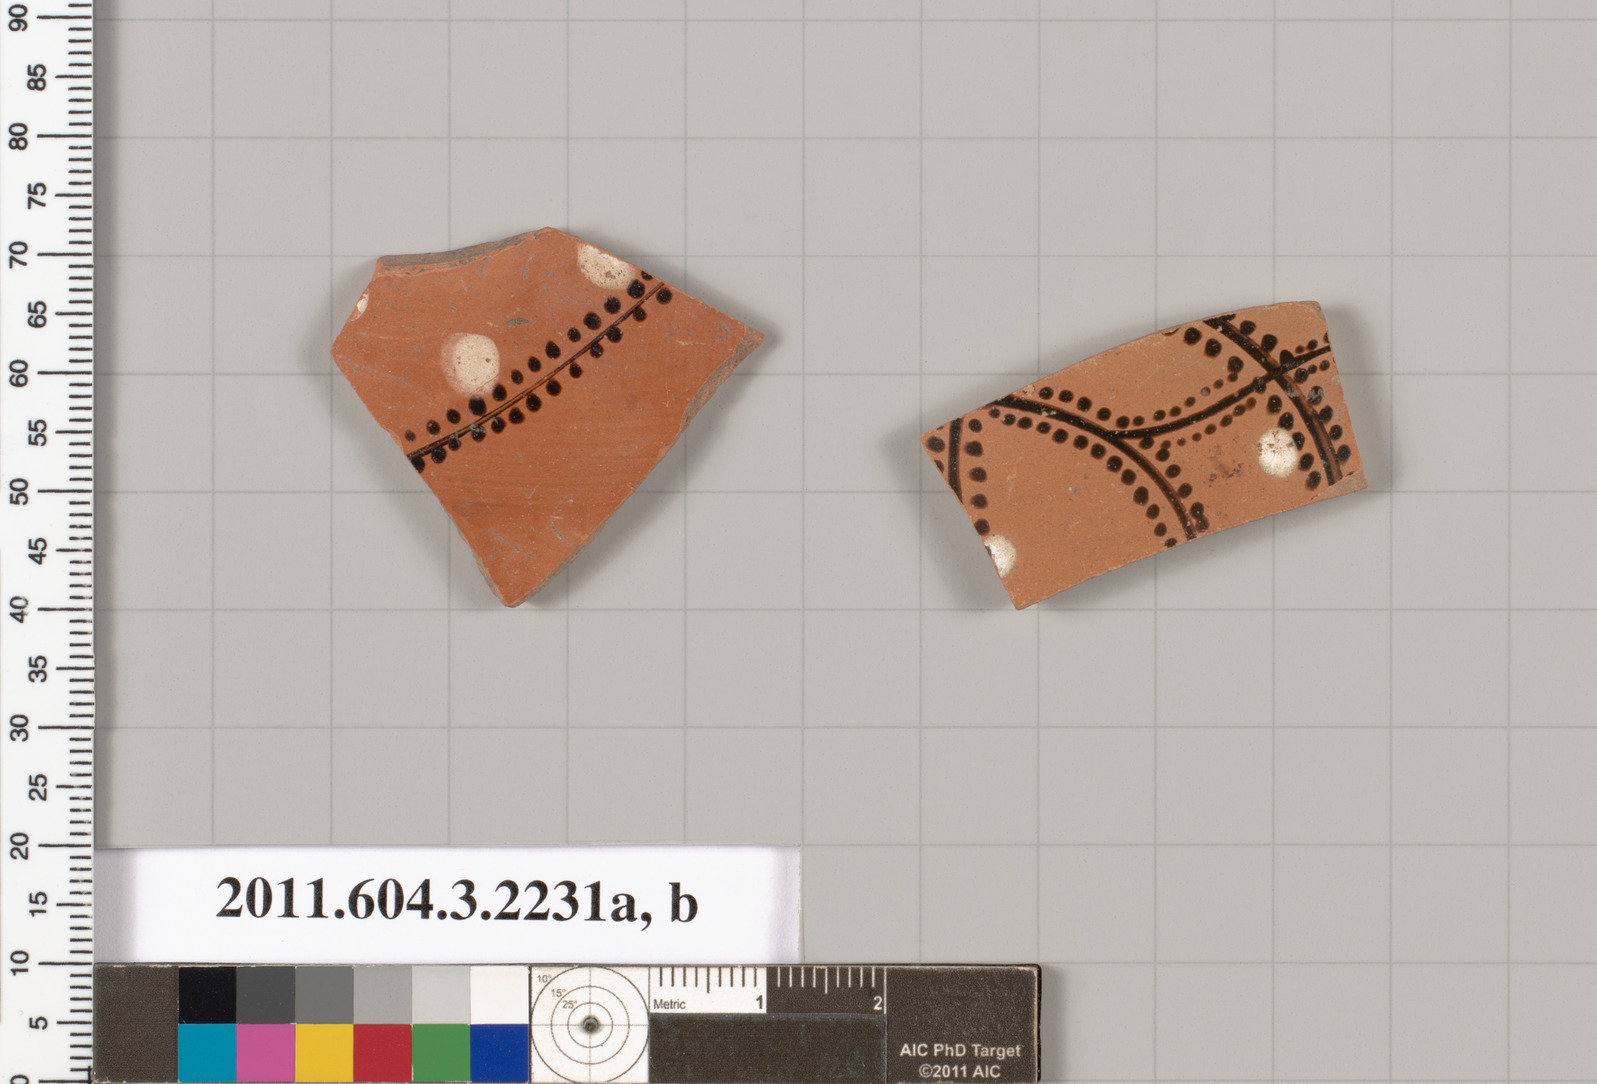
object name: kylix fragment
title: Terracotta fragments of kylikes (drinking cups)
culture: greek, attic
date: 525-501 BCE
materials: terracotta